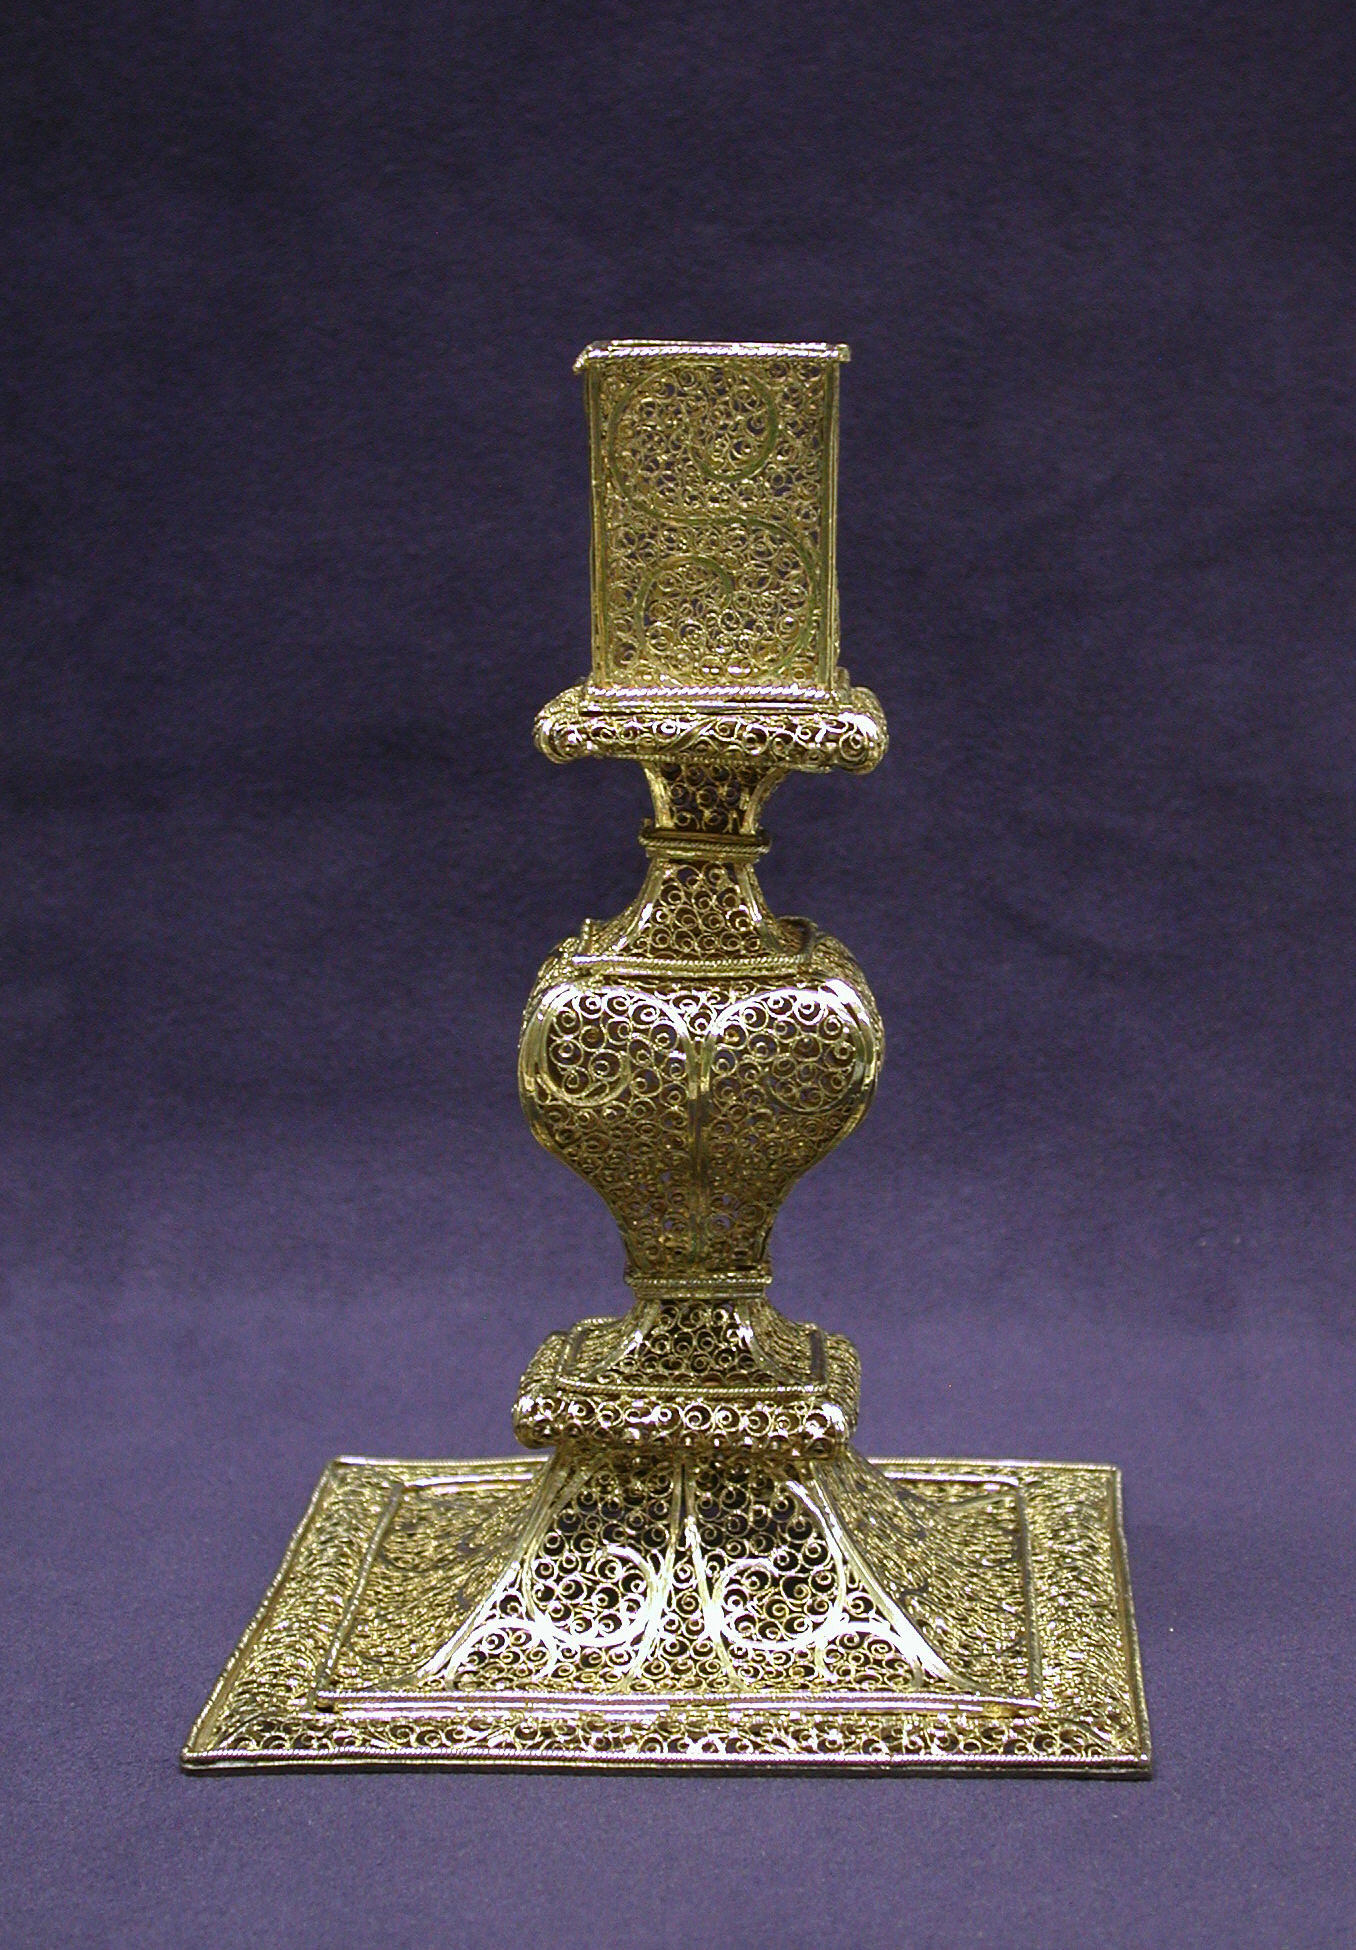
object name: candlestick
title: Pair of candlesticks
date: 1675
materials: silver gilt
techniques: filigree